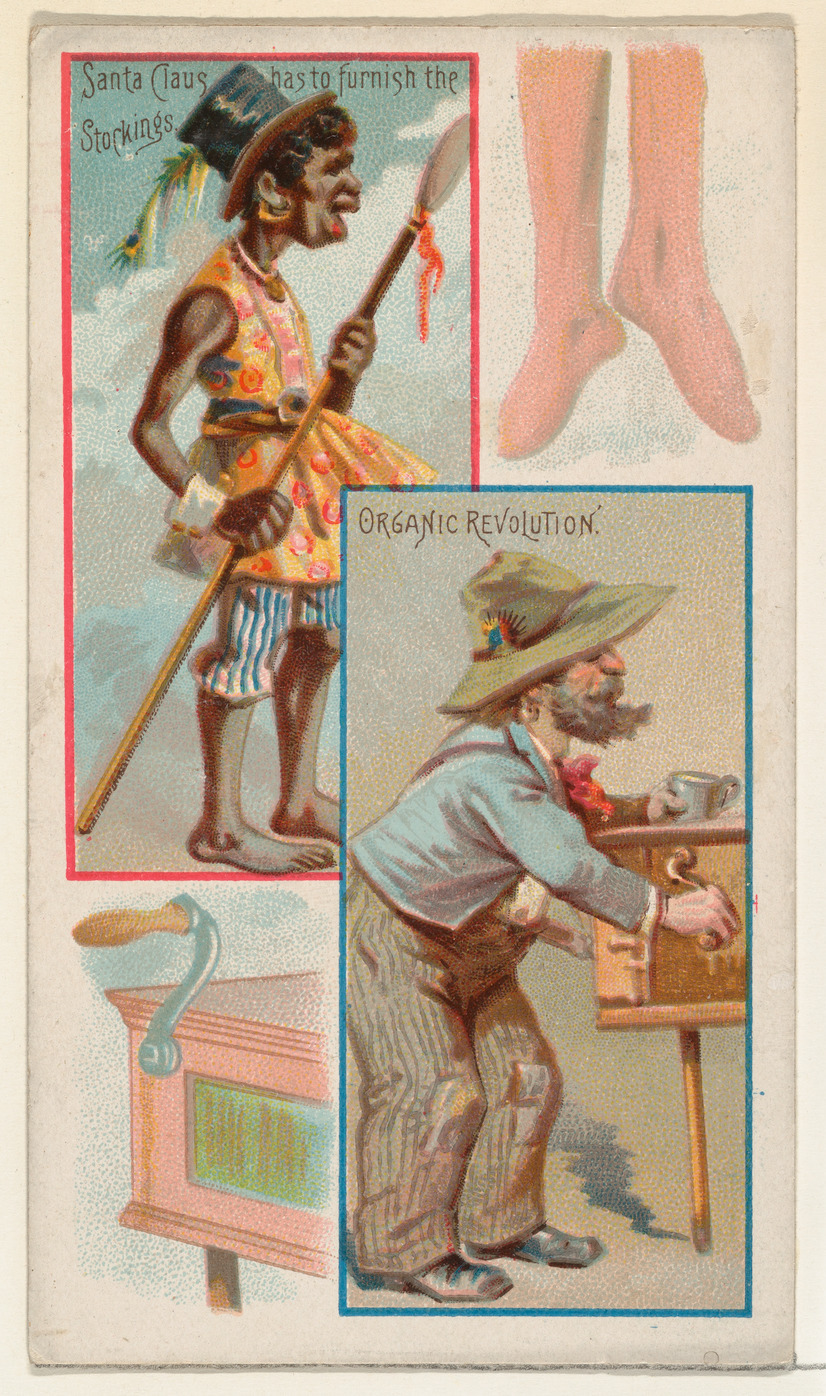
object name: print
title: Caricatured figures / Santa Claus has to Furnish the Stockings / Organic Revolution, from the Jokes series (N118) issued by Duke Sons & Co. to promote Honest Long Cut Tobacco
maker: w. duke, sons & co.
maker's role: publisher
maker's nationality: american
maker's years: 1870-1920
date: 1891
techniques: color lithograph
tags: men